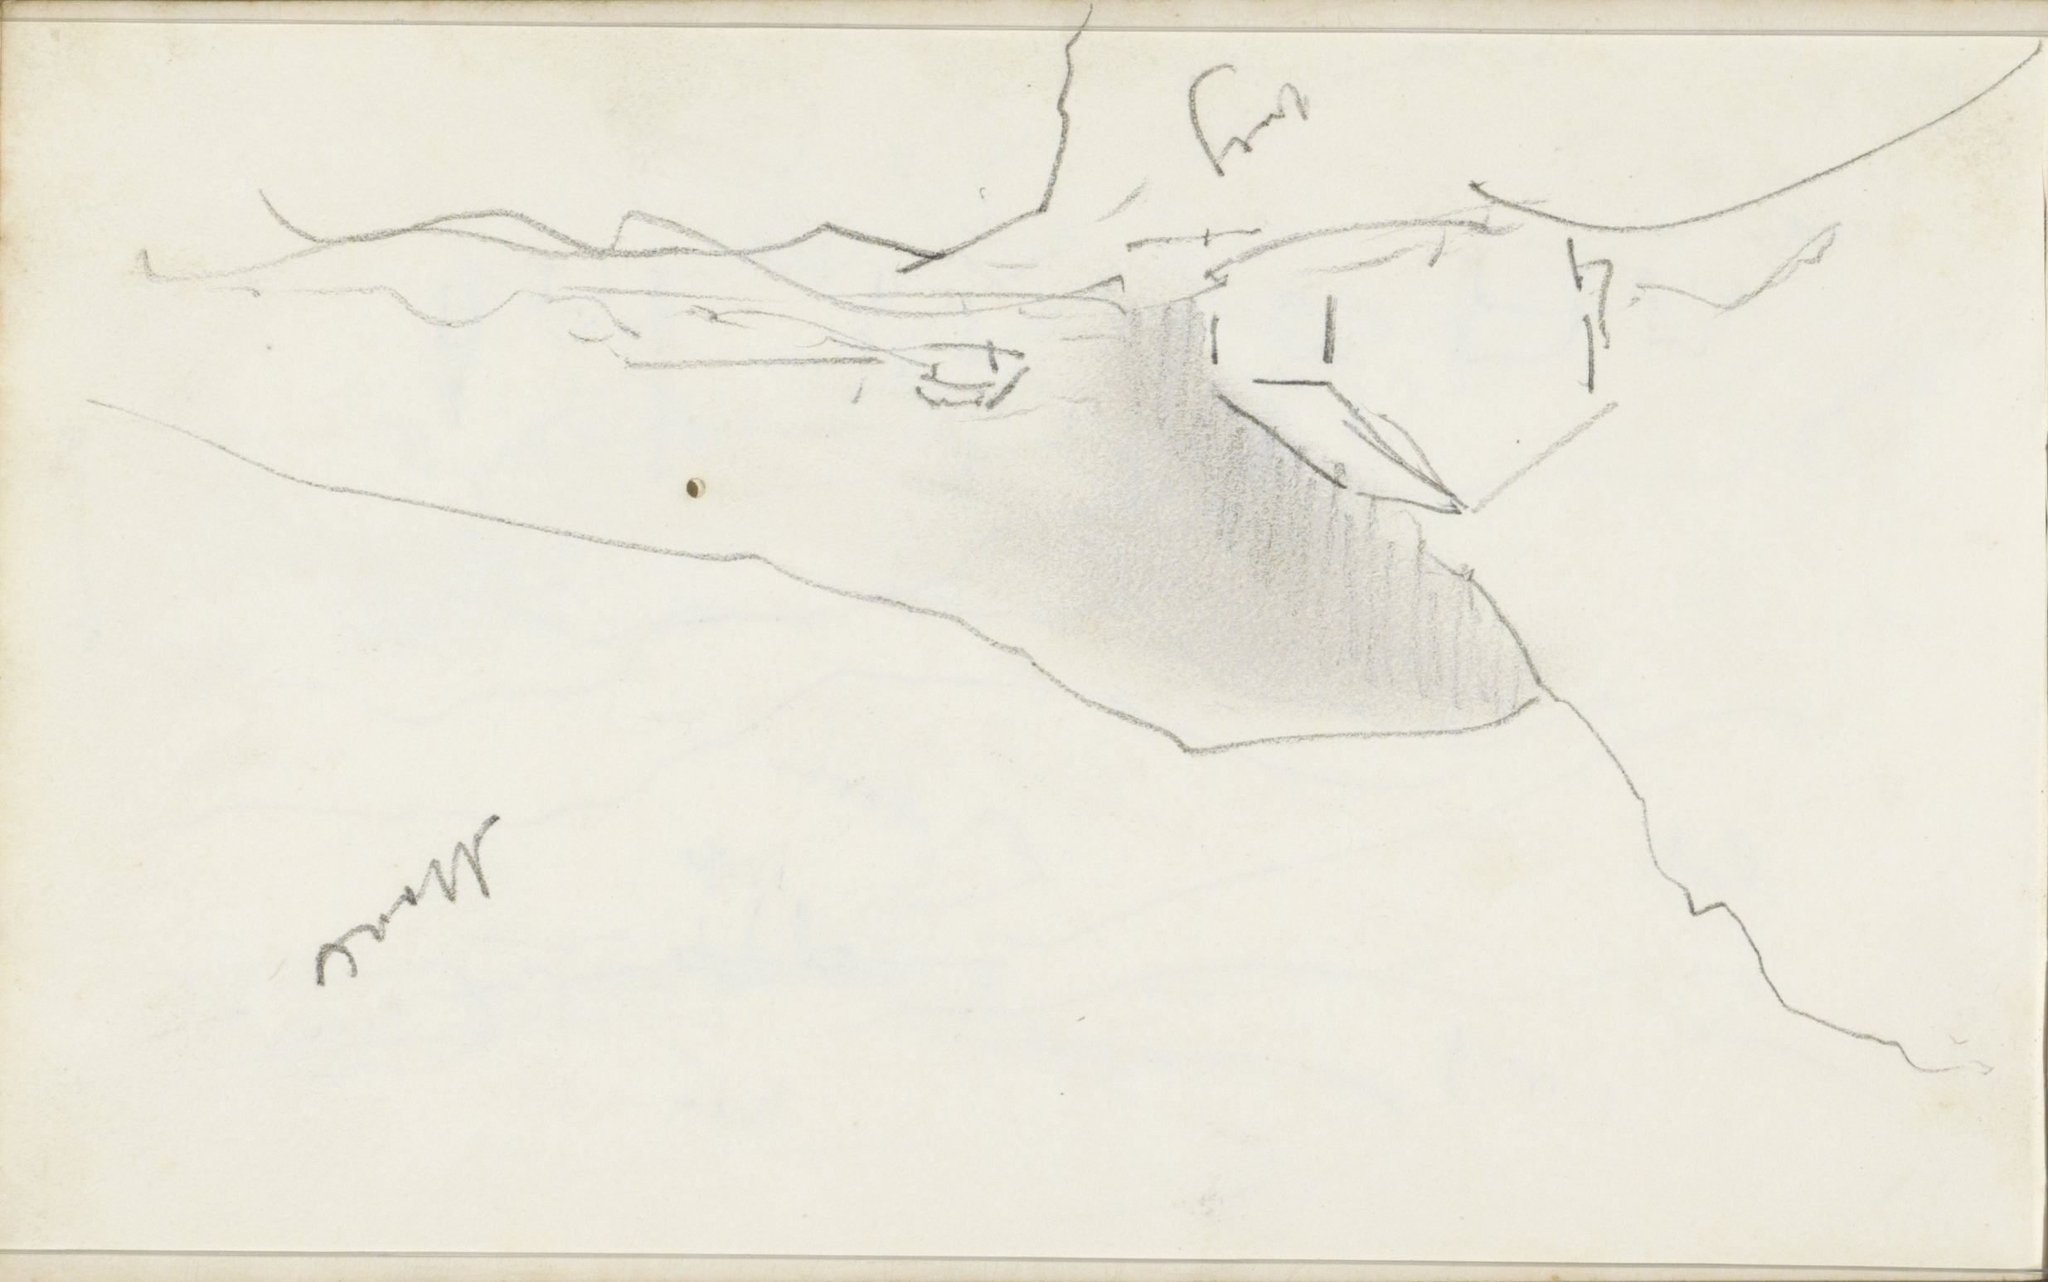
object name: sketchbook leaf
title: Huis aan een weg langs de Maas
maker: johannes tavenraat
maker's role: draughtsman, painter, print maker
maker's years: 1809-1881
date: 1840-1841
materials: paper, pencil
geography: meuse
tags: city-view, and landscape with man-made constructions, landscapes with waters, waterscapes, seascapes (in the temperate zone), road, path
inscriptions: annotation: ‘Maas/ weg’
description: Blad 25 verso uit een schetsboek met 41 bladen.